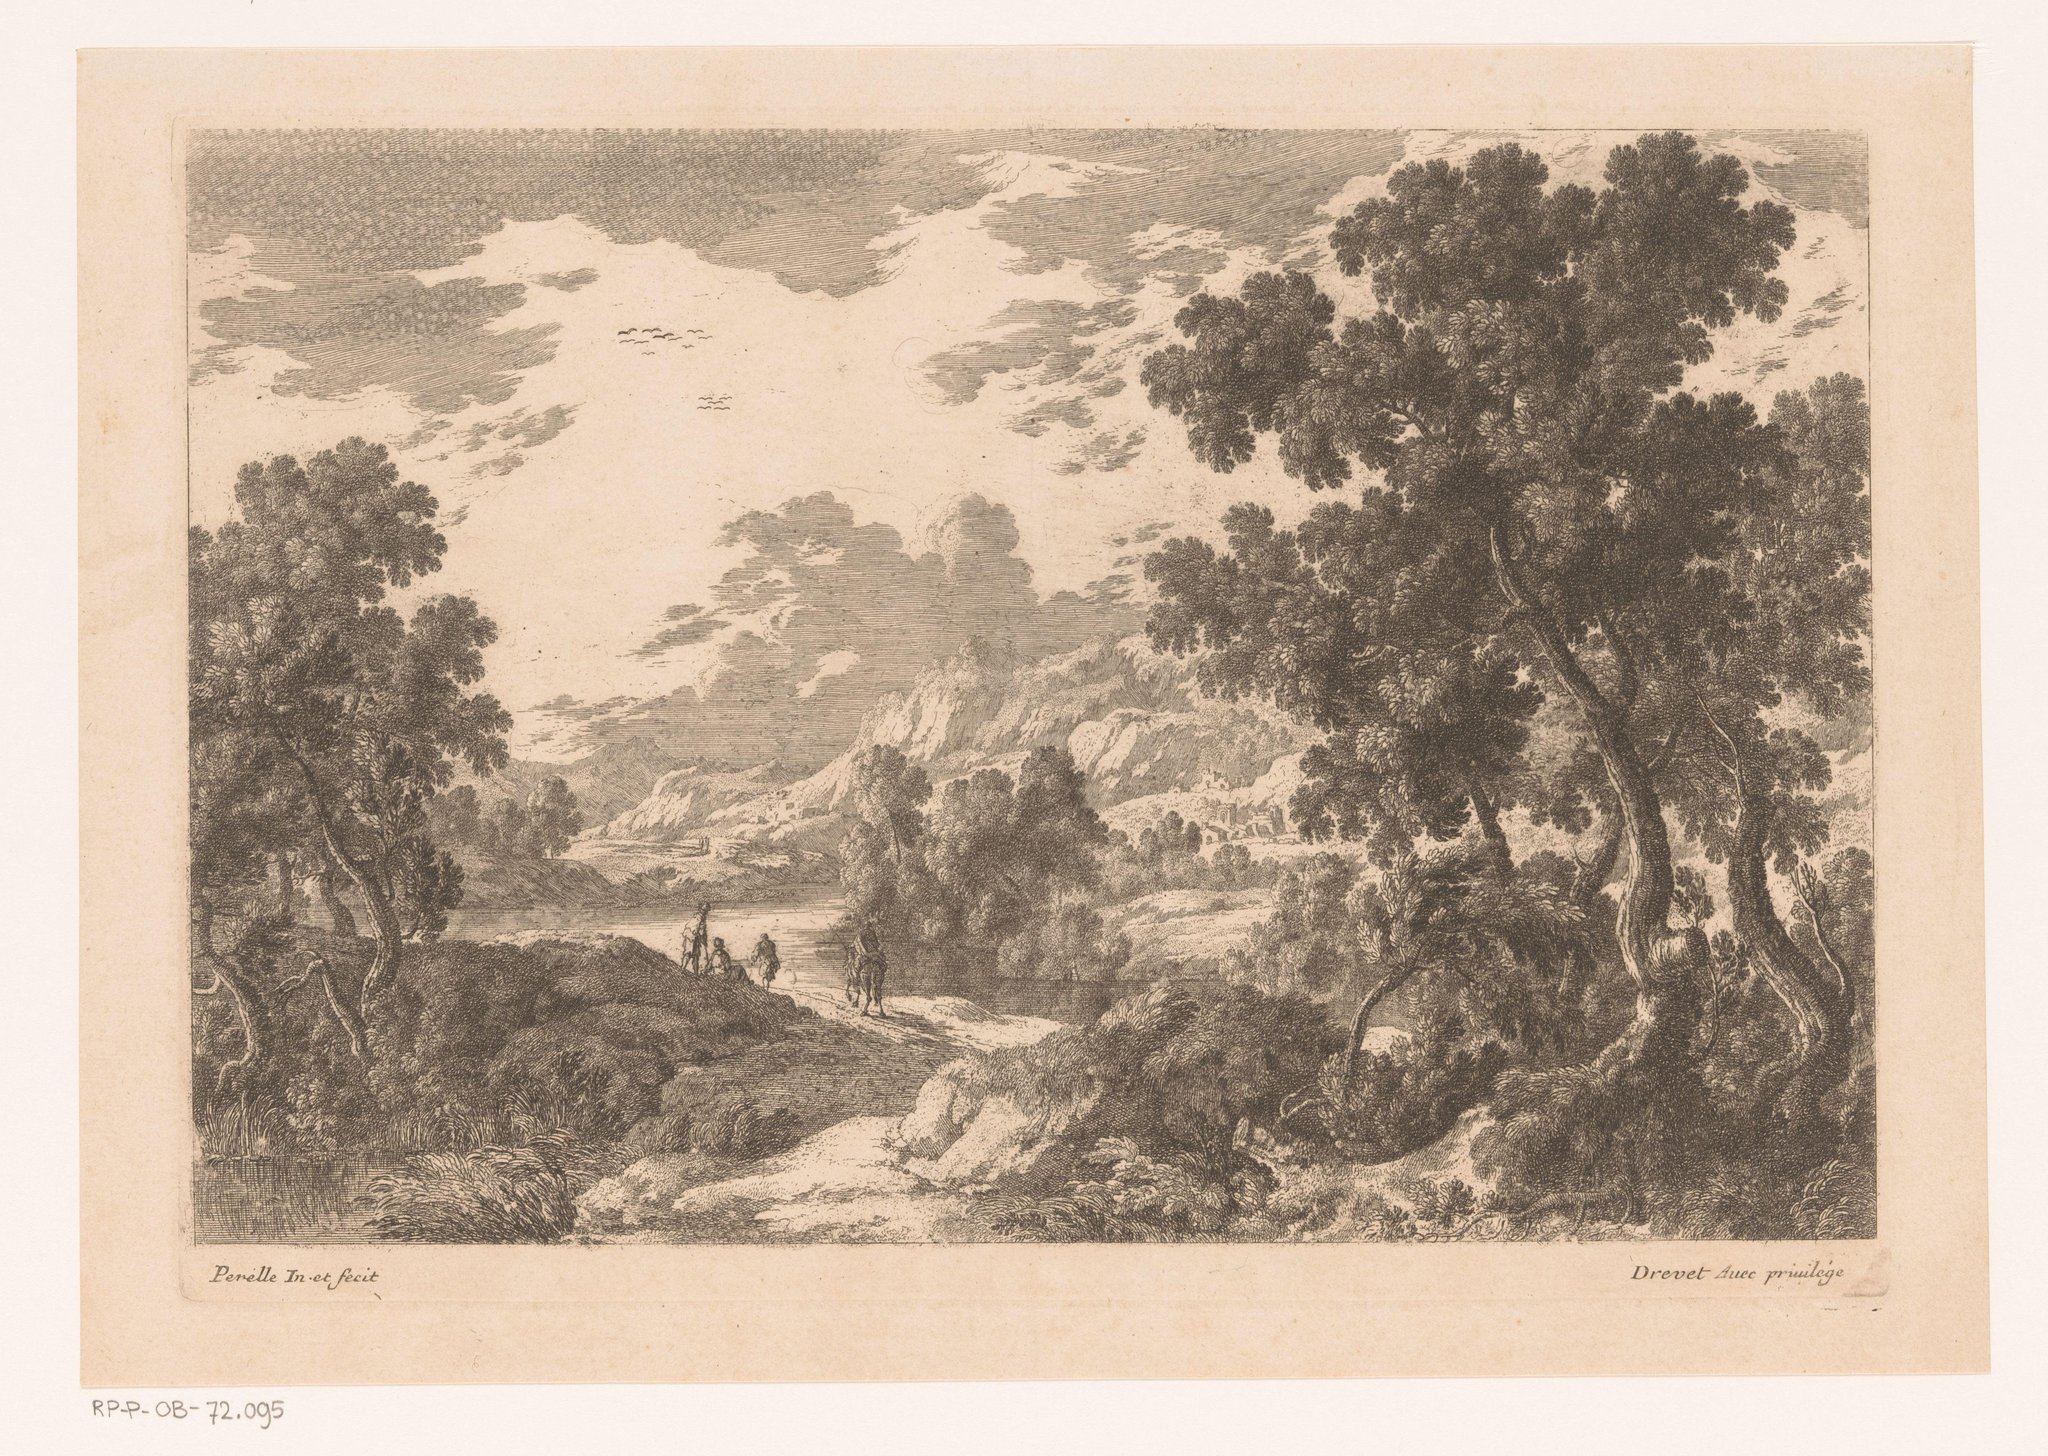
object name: print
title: Rivierlandschap met vier figuren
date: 1673-1695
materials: paper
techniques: engraving, etching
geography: paris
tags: landscapes with waters, waterscapes, seascapes (in the temperate zone)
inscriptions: collector's mark: Lugt 2228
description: Prenten met het signatuur 'Perelle' kunnen zowel door vader Gabriel als door zonen Nicolas en Adam gemaakt zijn.